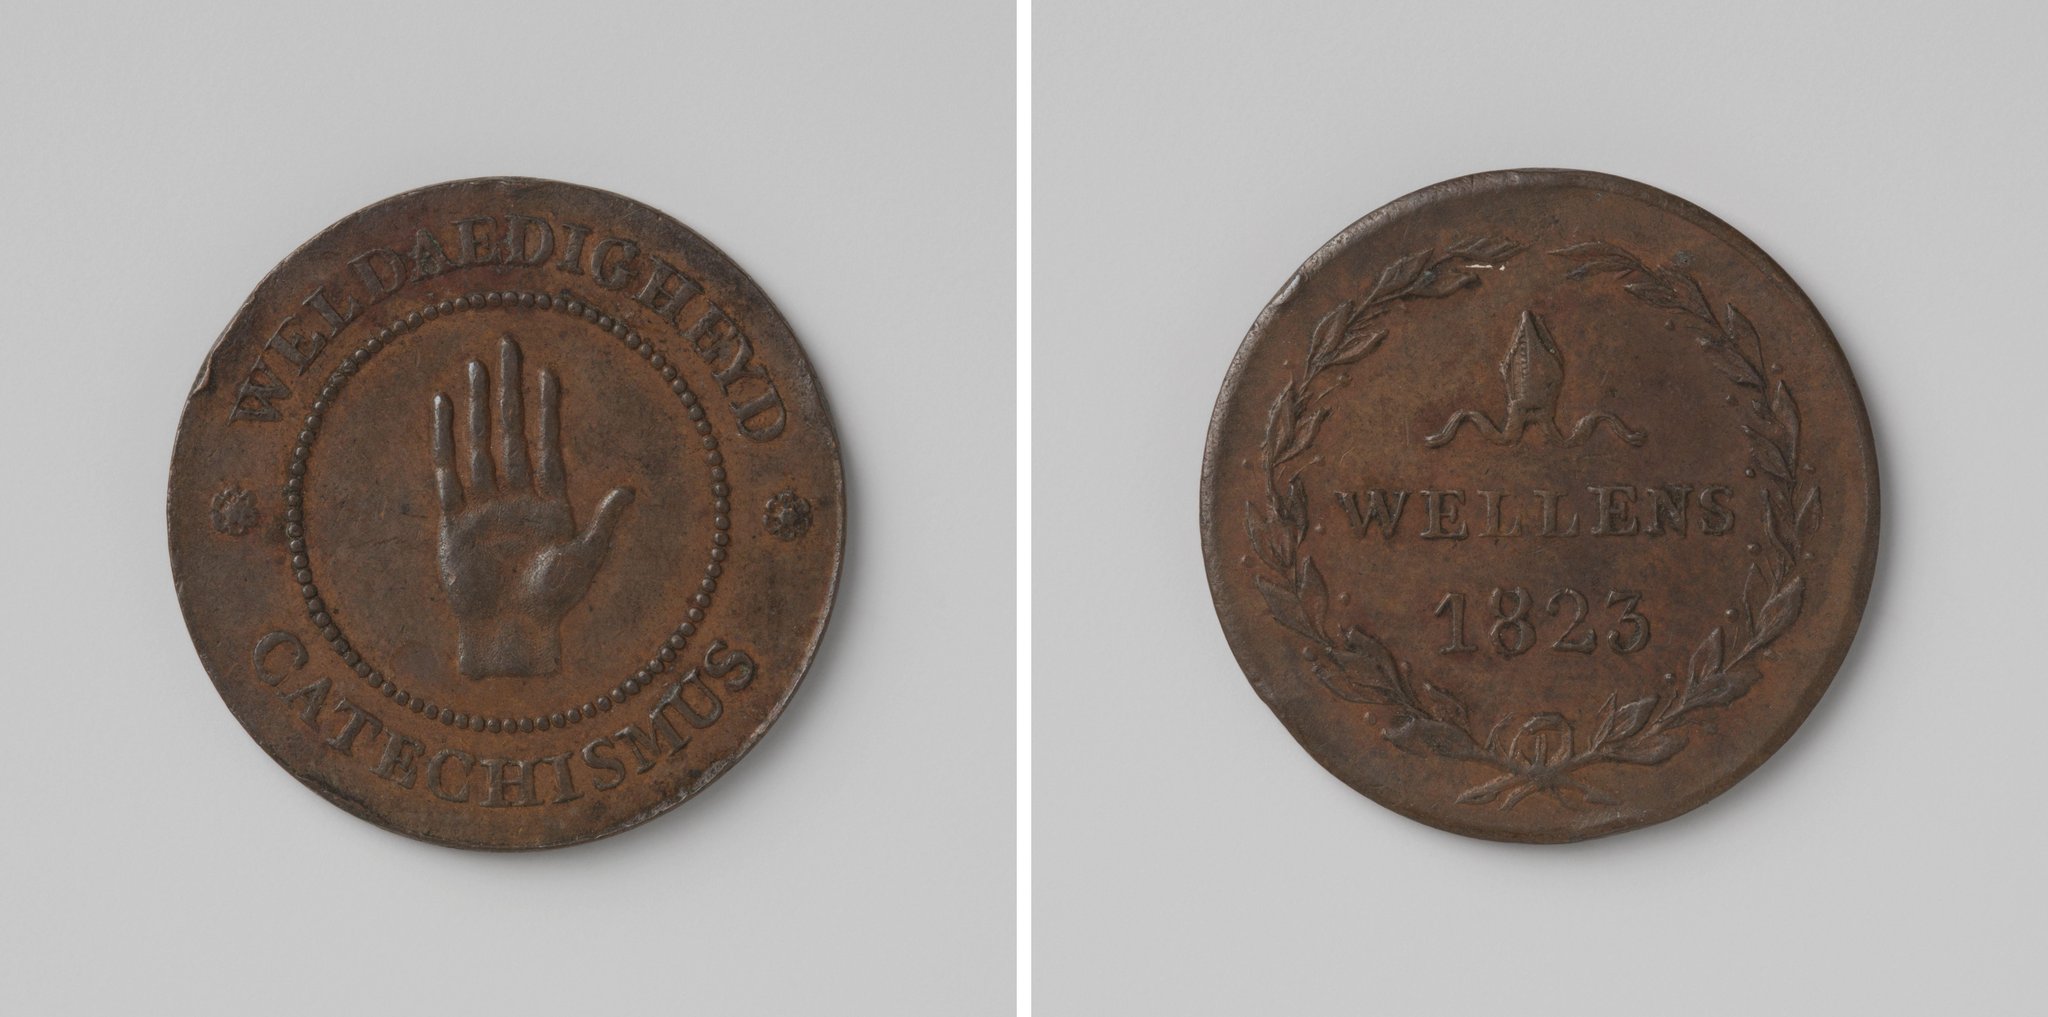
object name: alms token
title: Fonds Wellens te Antwerpen, penning uitgereikt aan de armen die op zondag de catechismus bijwoonden, goed voor een brood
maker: Anonymous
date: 1823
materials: copper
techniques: striking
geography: antwerp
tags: antwerp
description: Koperen penning. Voorzijde: geopende hand binnen omschrift. Keerzijde: opschrift en jaartal onder bisschoppelijke mijter binnen lauwerkrans.